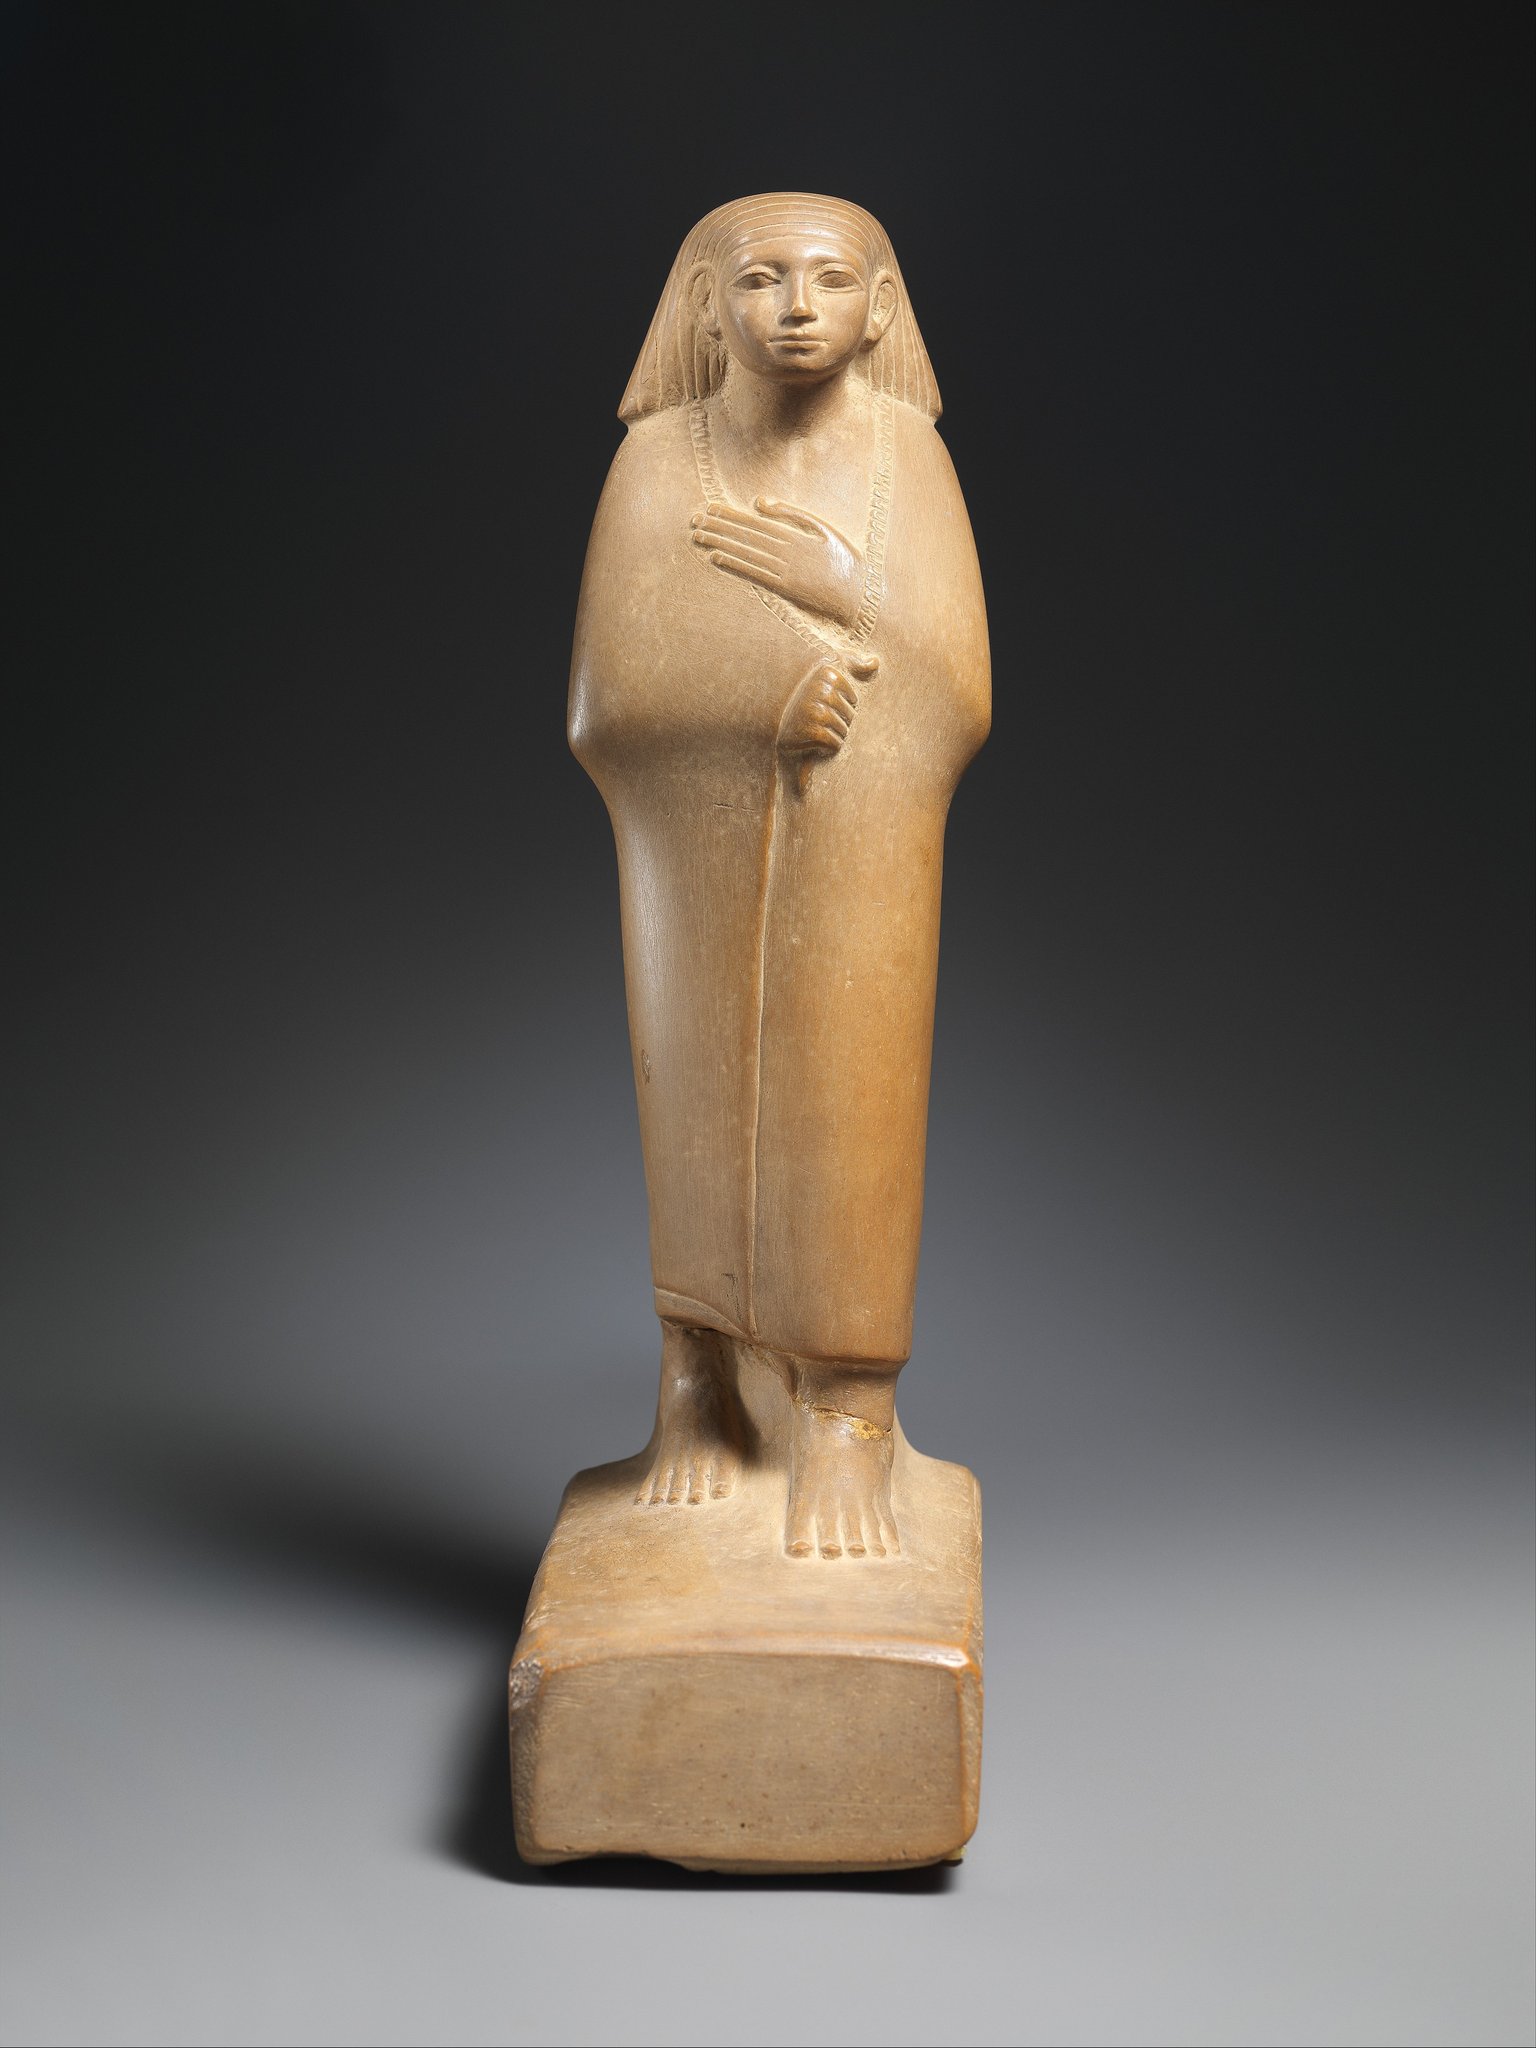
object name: statue, seated man, cloak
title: Statuette of a Cloaked Man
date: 1850 BCE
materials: limestone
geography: egypt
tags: men